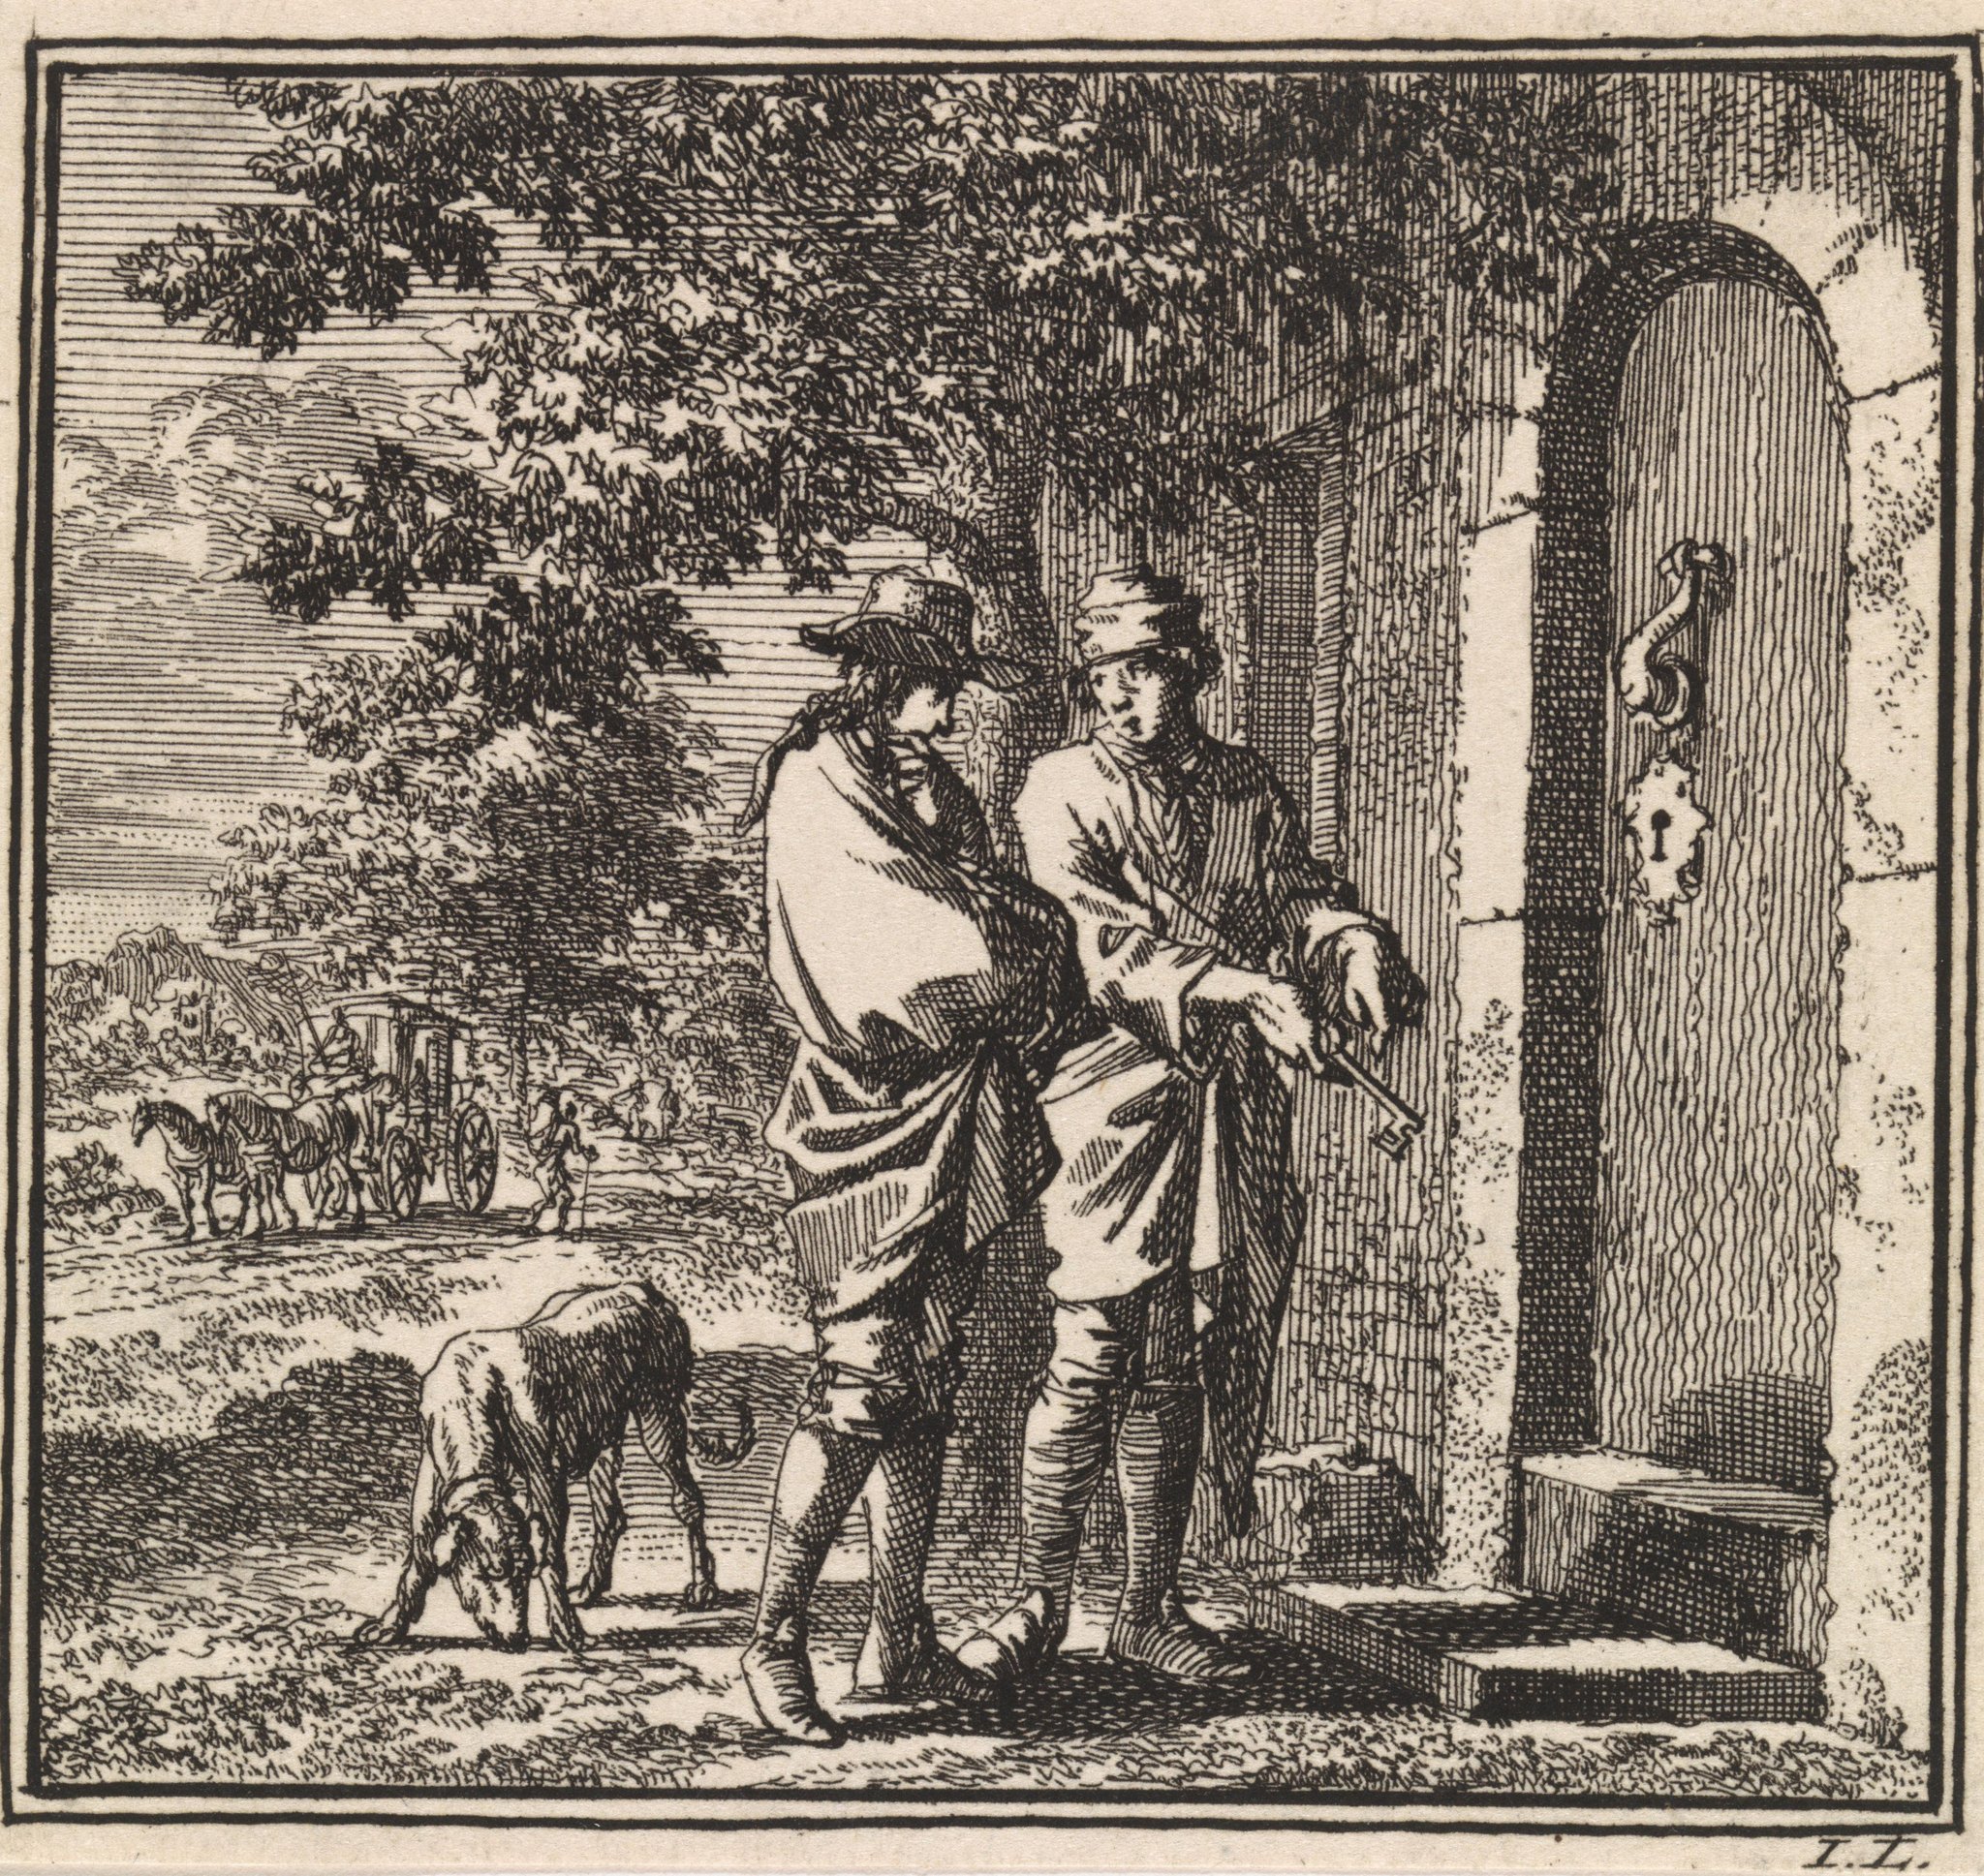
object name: book illustration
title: De Sleutel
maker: jan luyken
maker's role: draughtsman, print maker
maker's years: 1649-1712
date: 1711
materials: paper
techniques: etching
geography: amsterdam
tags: key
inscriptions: collector's mark: Lugt 2228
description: Illustratie voor: Luyken, Jan. De Bykorf des Gemoeds. Amsterdam: Pieter Arentsz. II (wed.) en Cornelis van der Sys, 1711, p. 286.